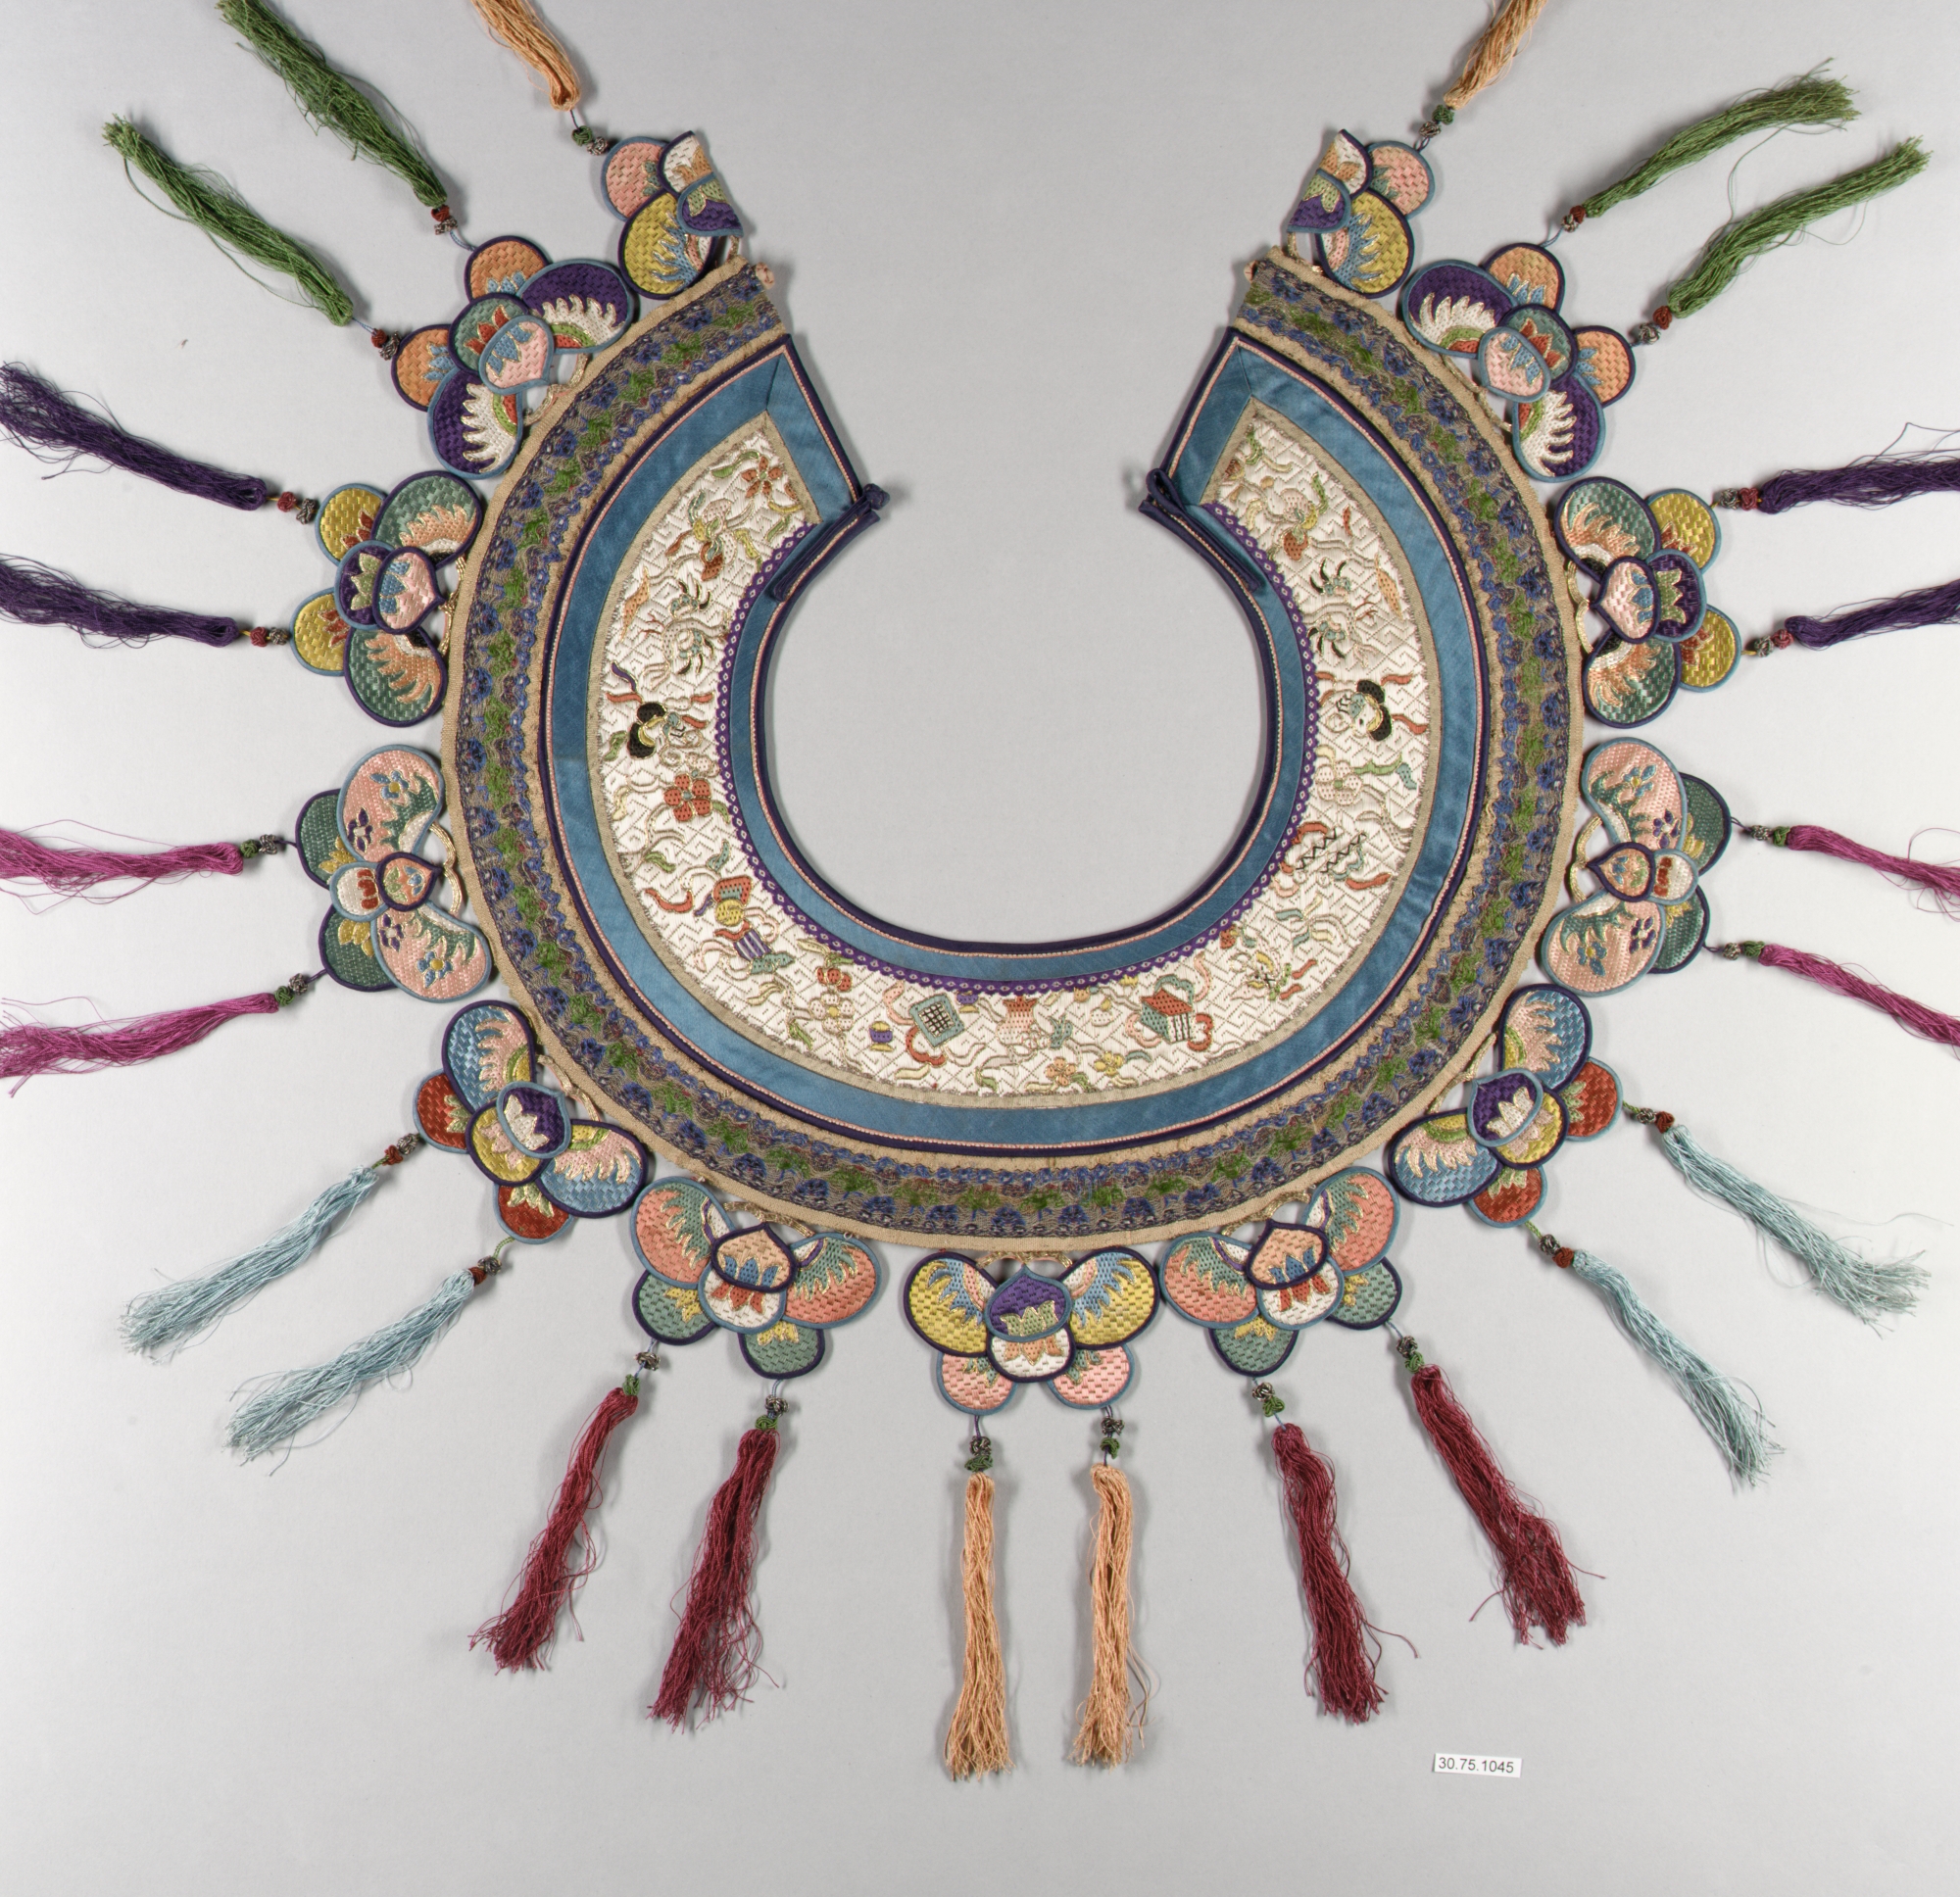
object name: collar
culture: chinese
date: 1801-1900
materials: metal thread, silk